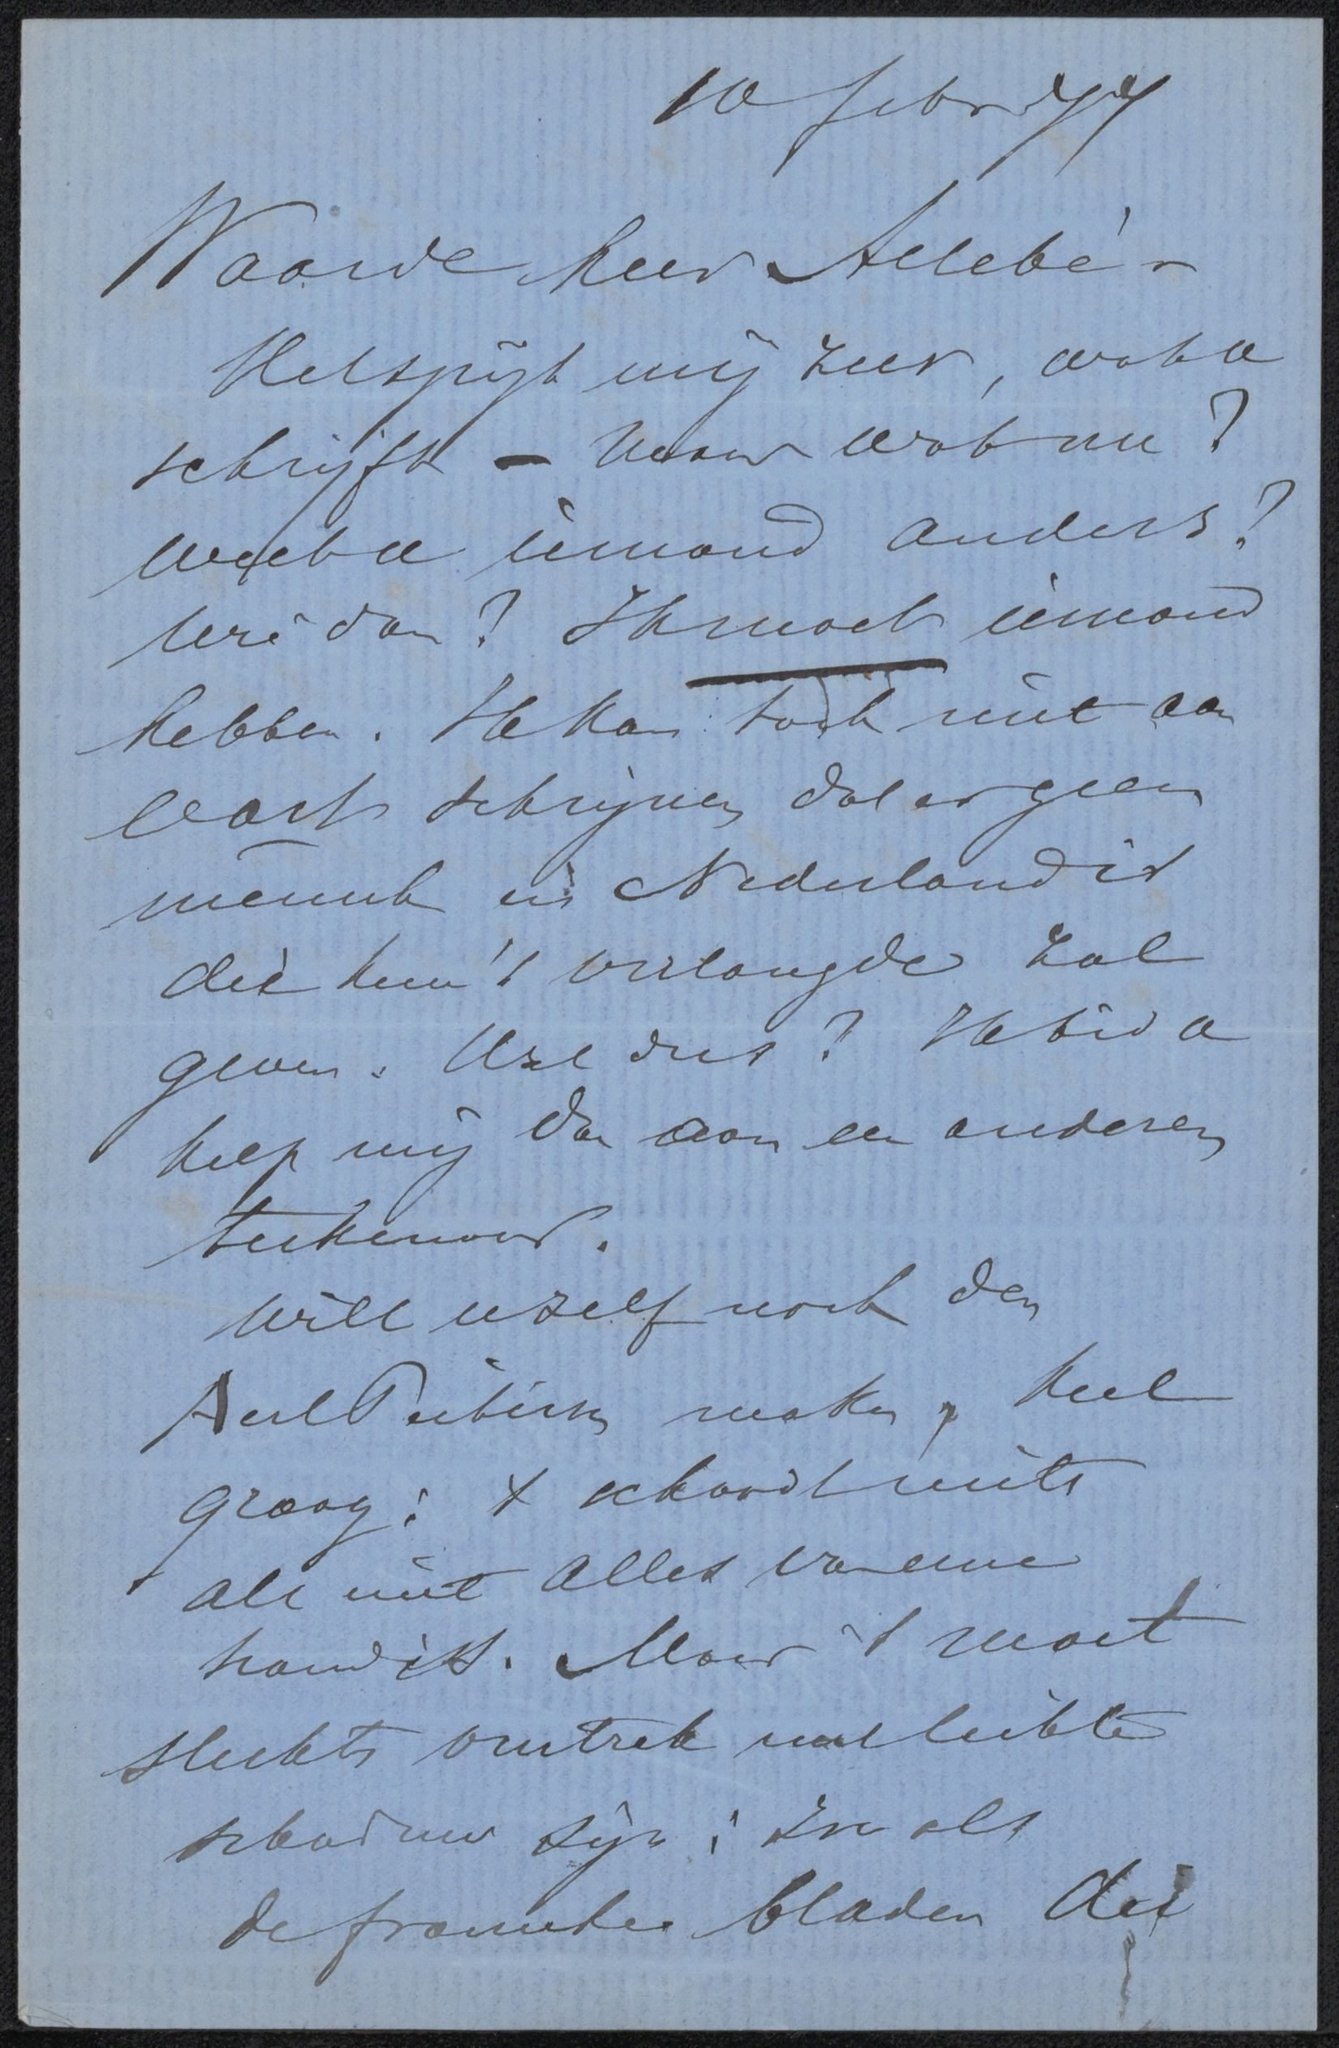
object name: letter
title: Brief aan August Allebé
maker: carel vosmaer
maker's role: draughtsman, print maker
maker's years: 1826-1888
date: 1877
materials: ink, paper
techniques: pen, writing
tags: amsterdam, painter, draughtsman, aert pietersz., august allebé, drawing